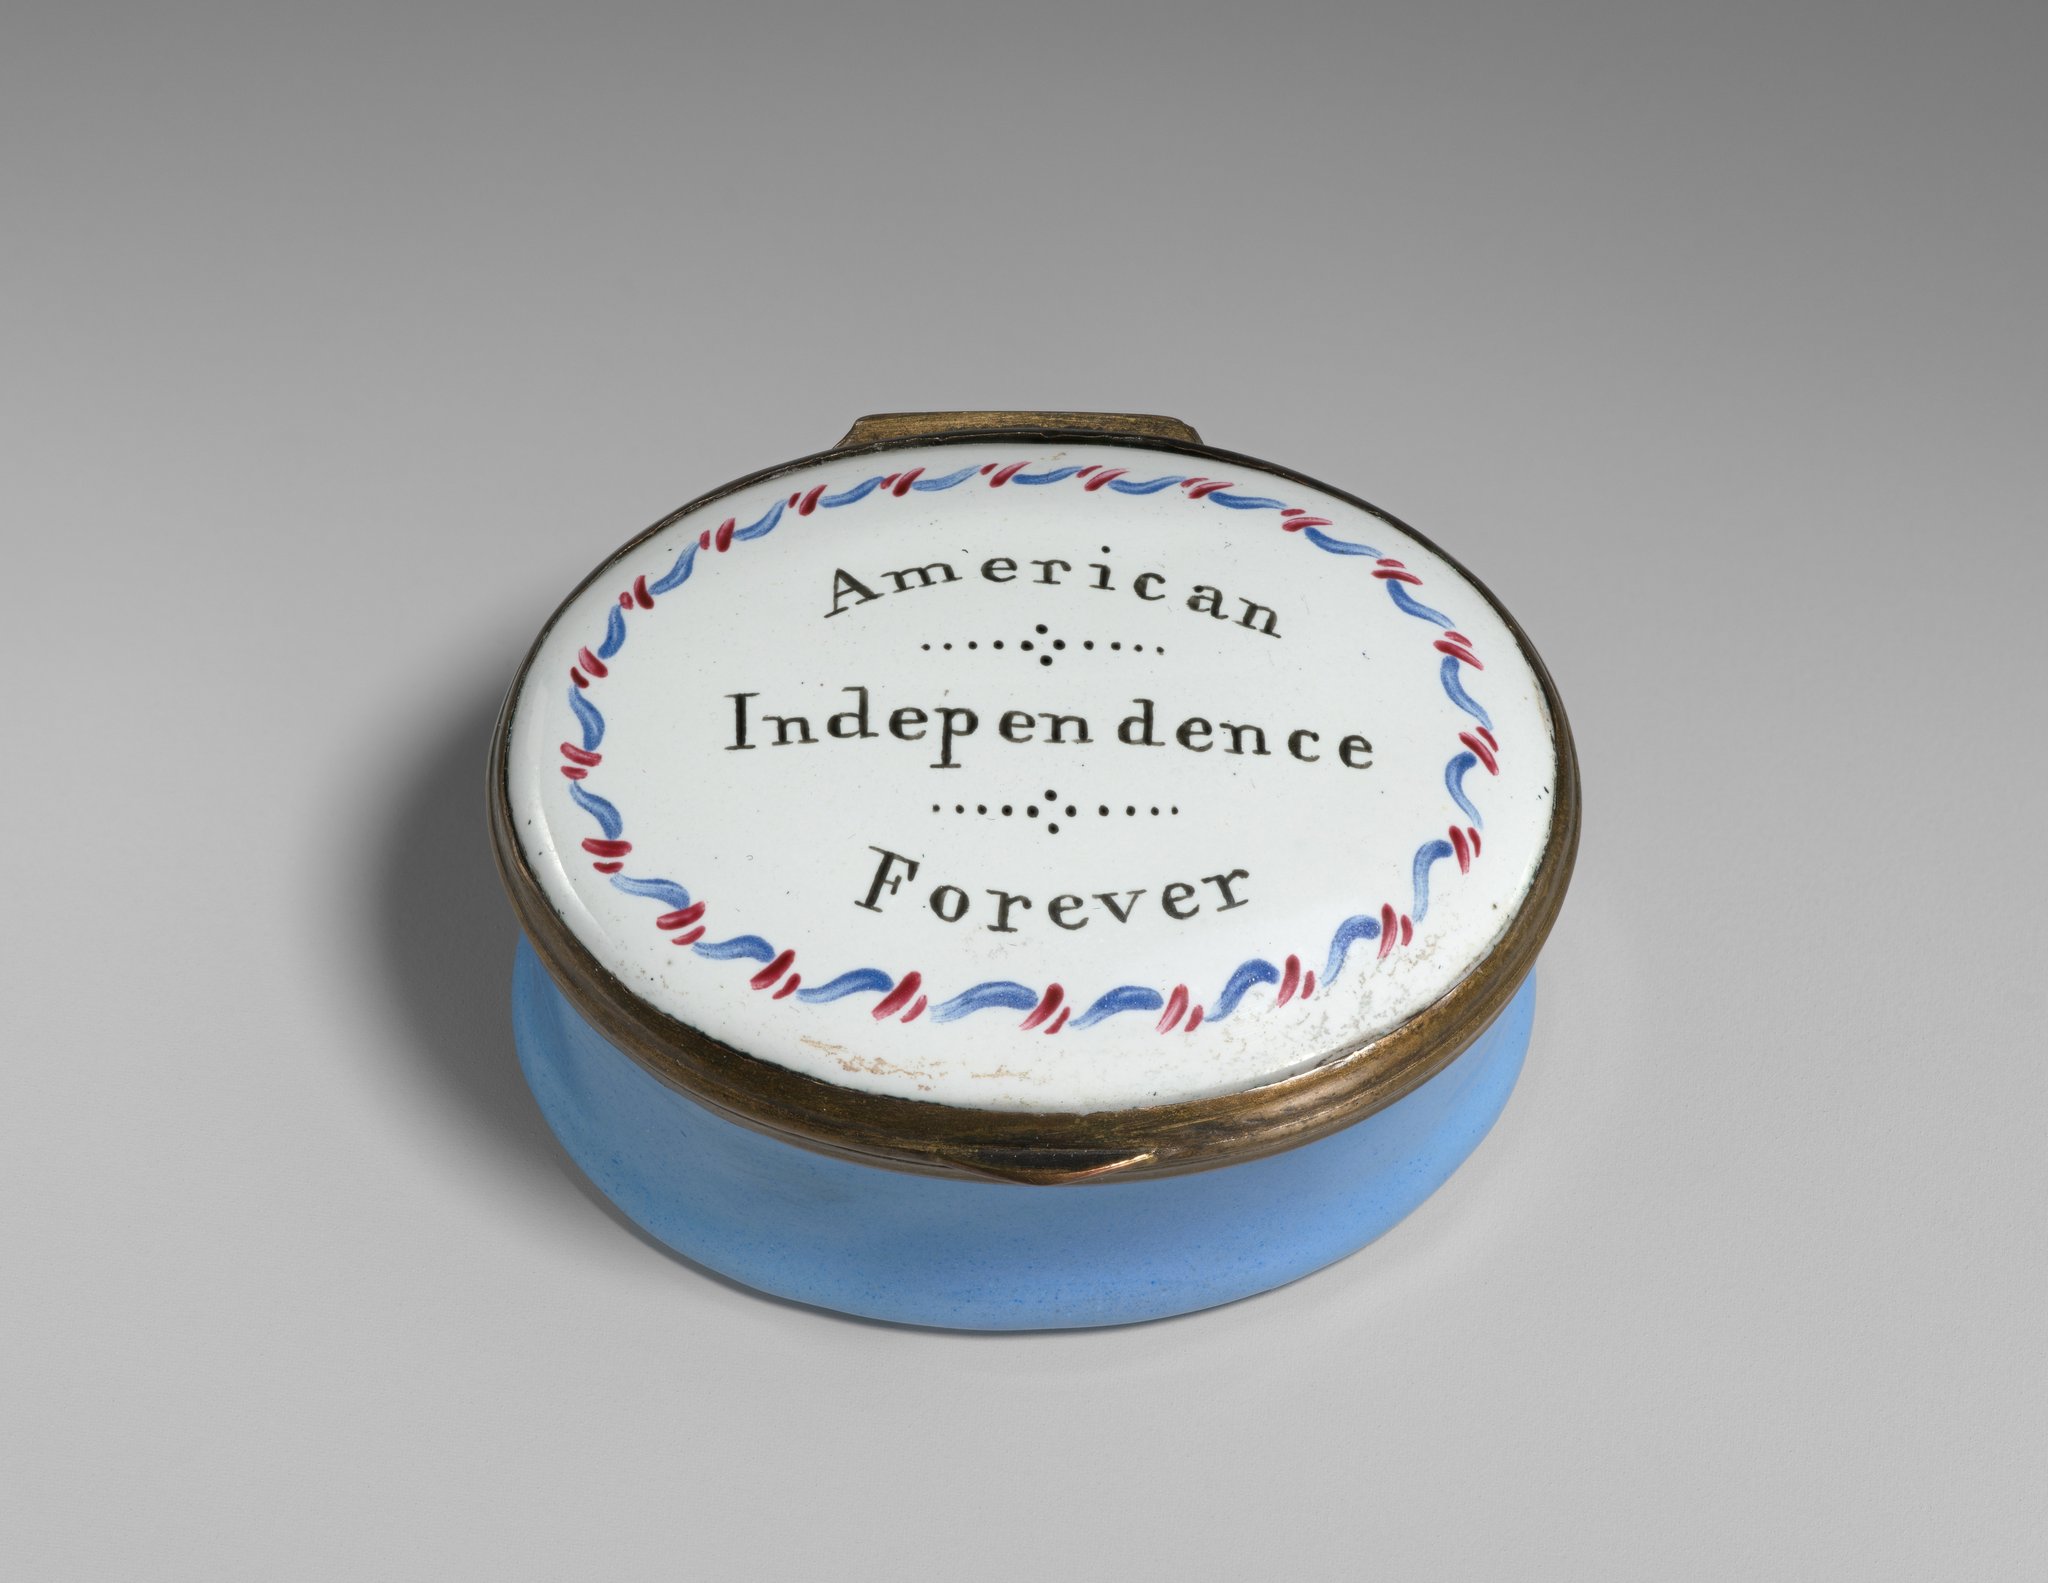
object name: patch box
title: Patch Box "American Independence Forever"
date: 1790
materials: copper, enamel, glass